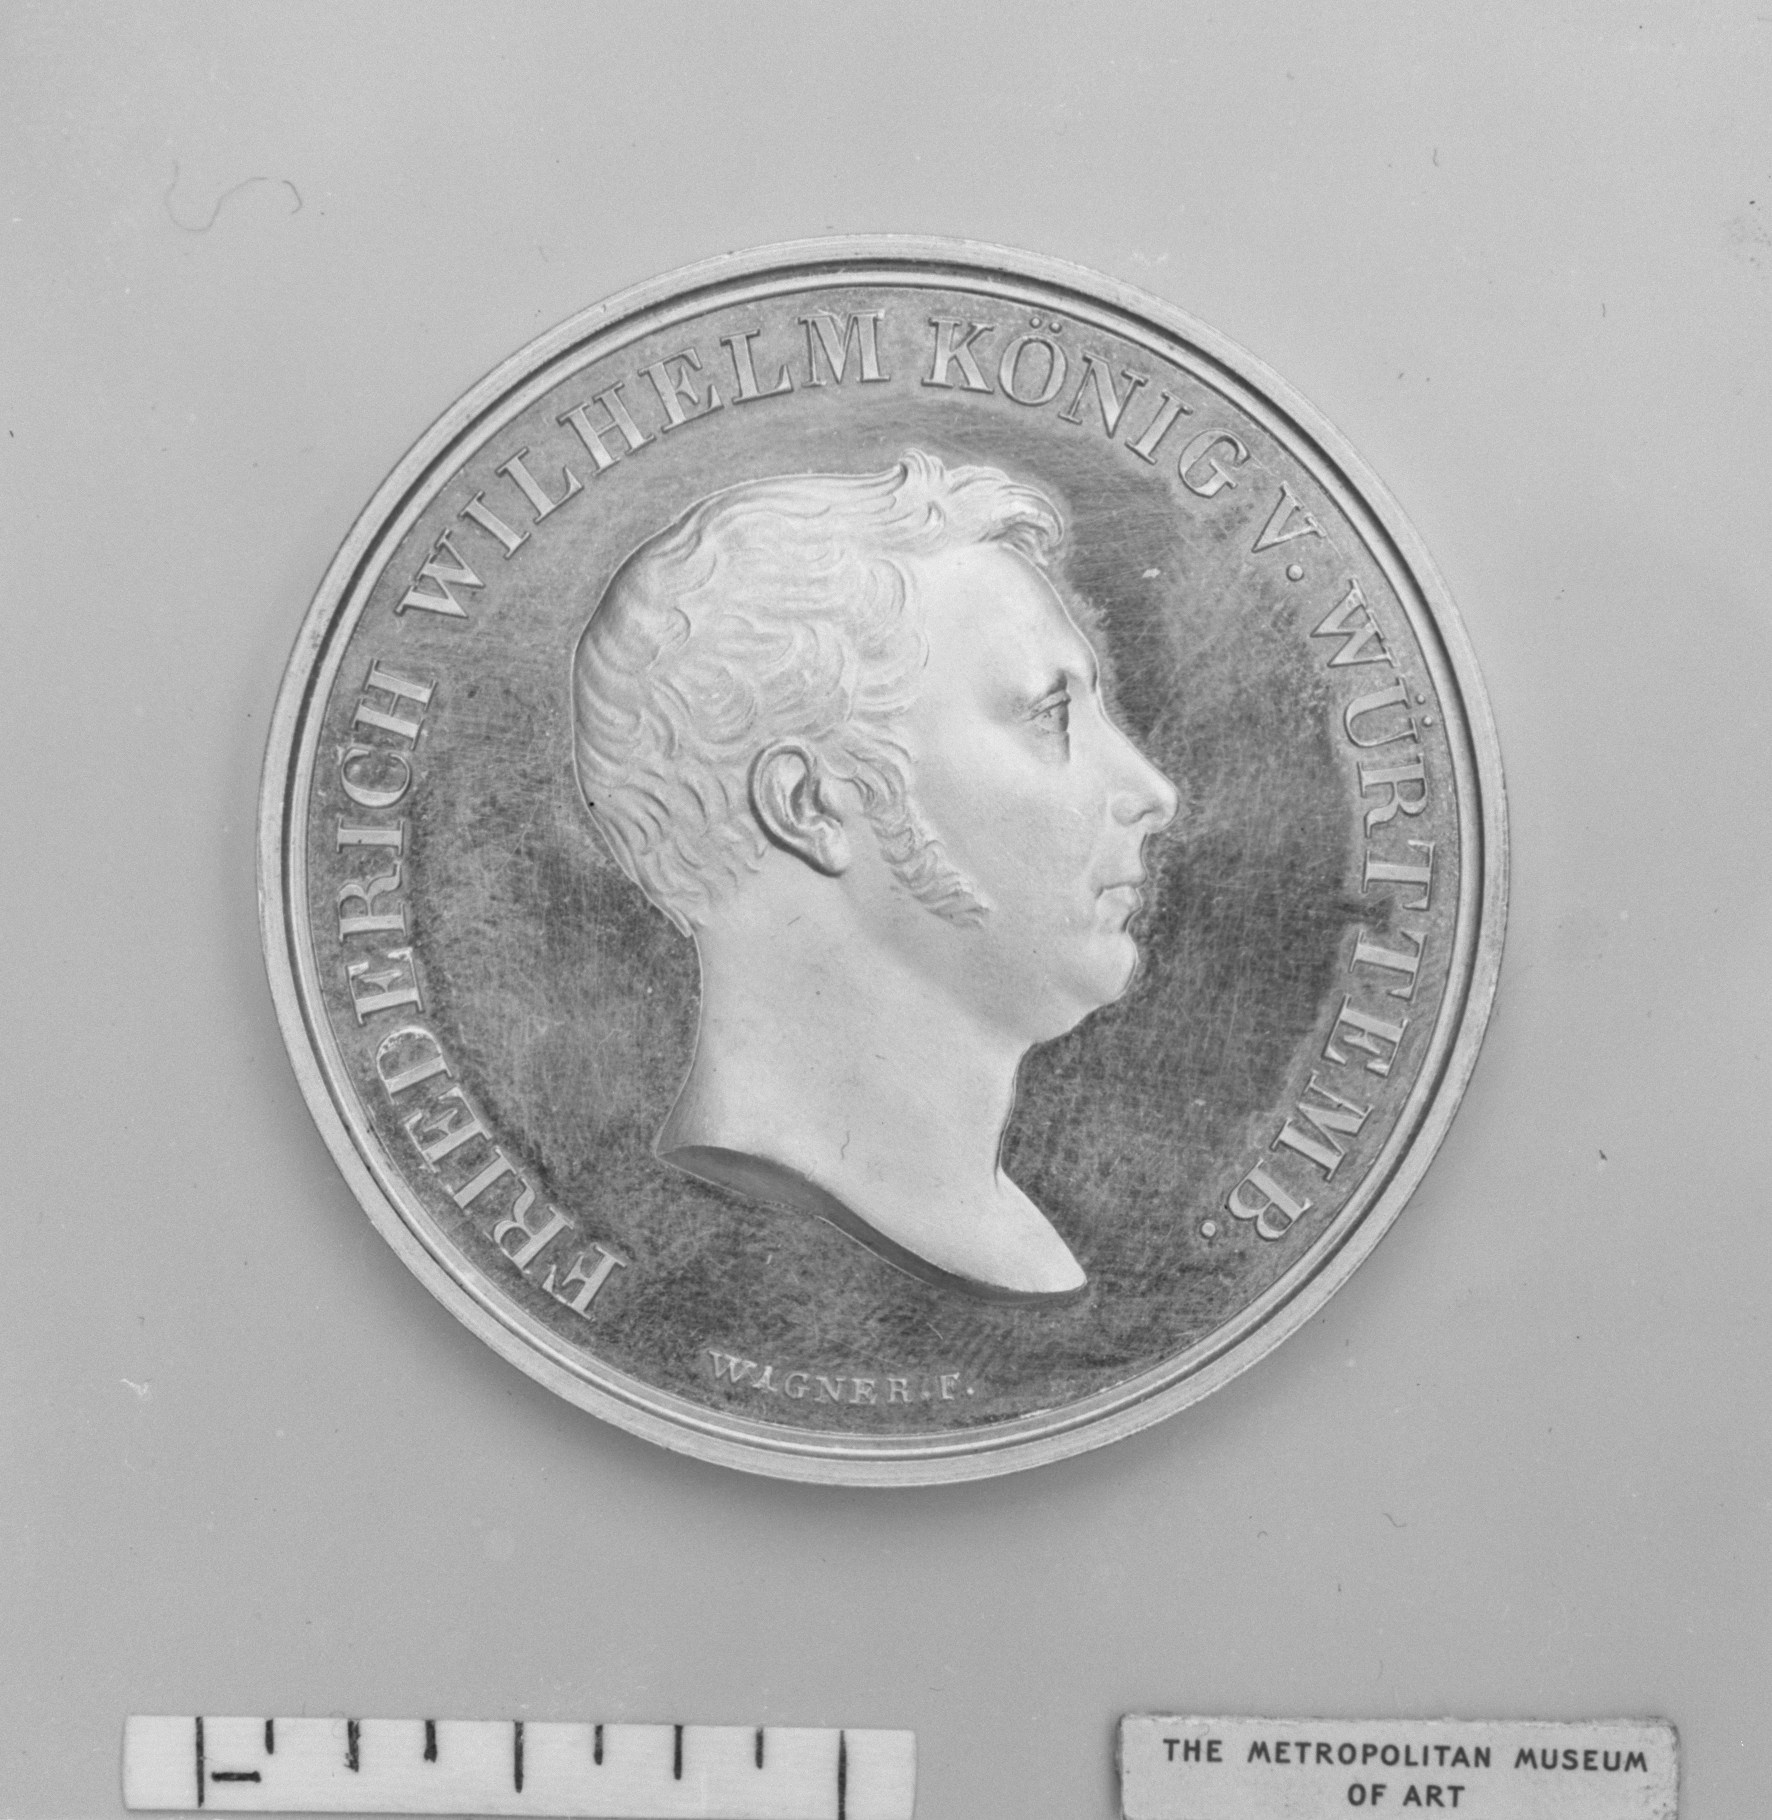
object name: medal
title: In Honor of King Friedrich William of Wurtemburg, Known as William I (1816–64)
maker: f. wagner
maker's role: artist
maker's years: 1775-1875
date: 1826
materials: gold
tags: kings,profiles